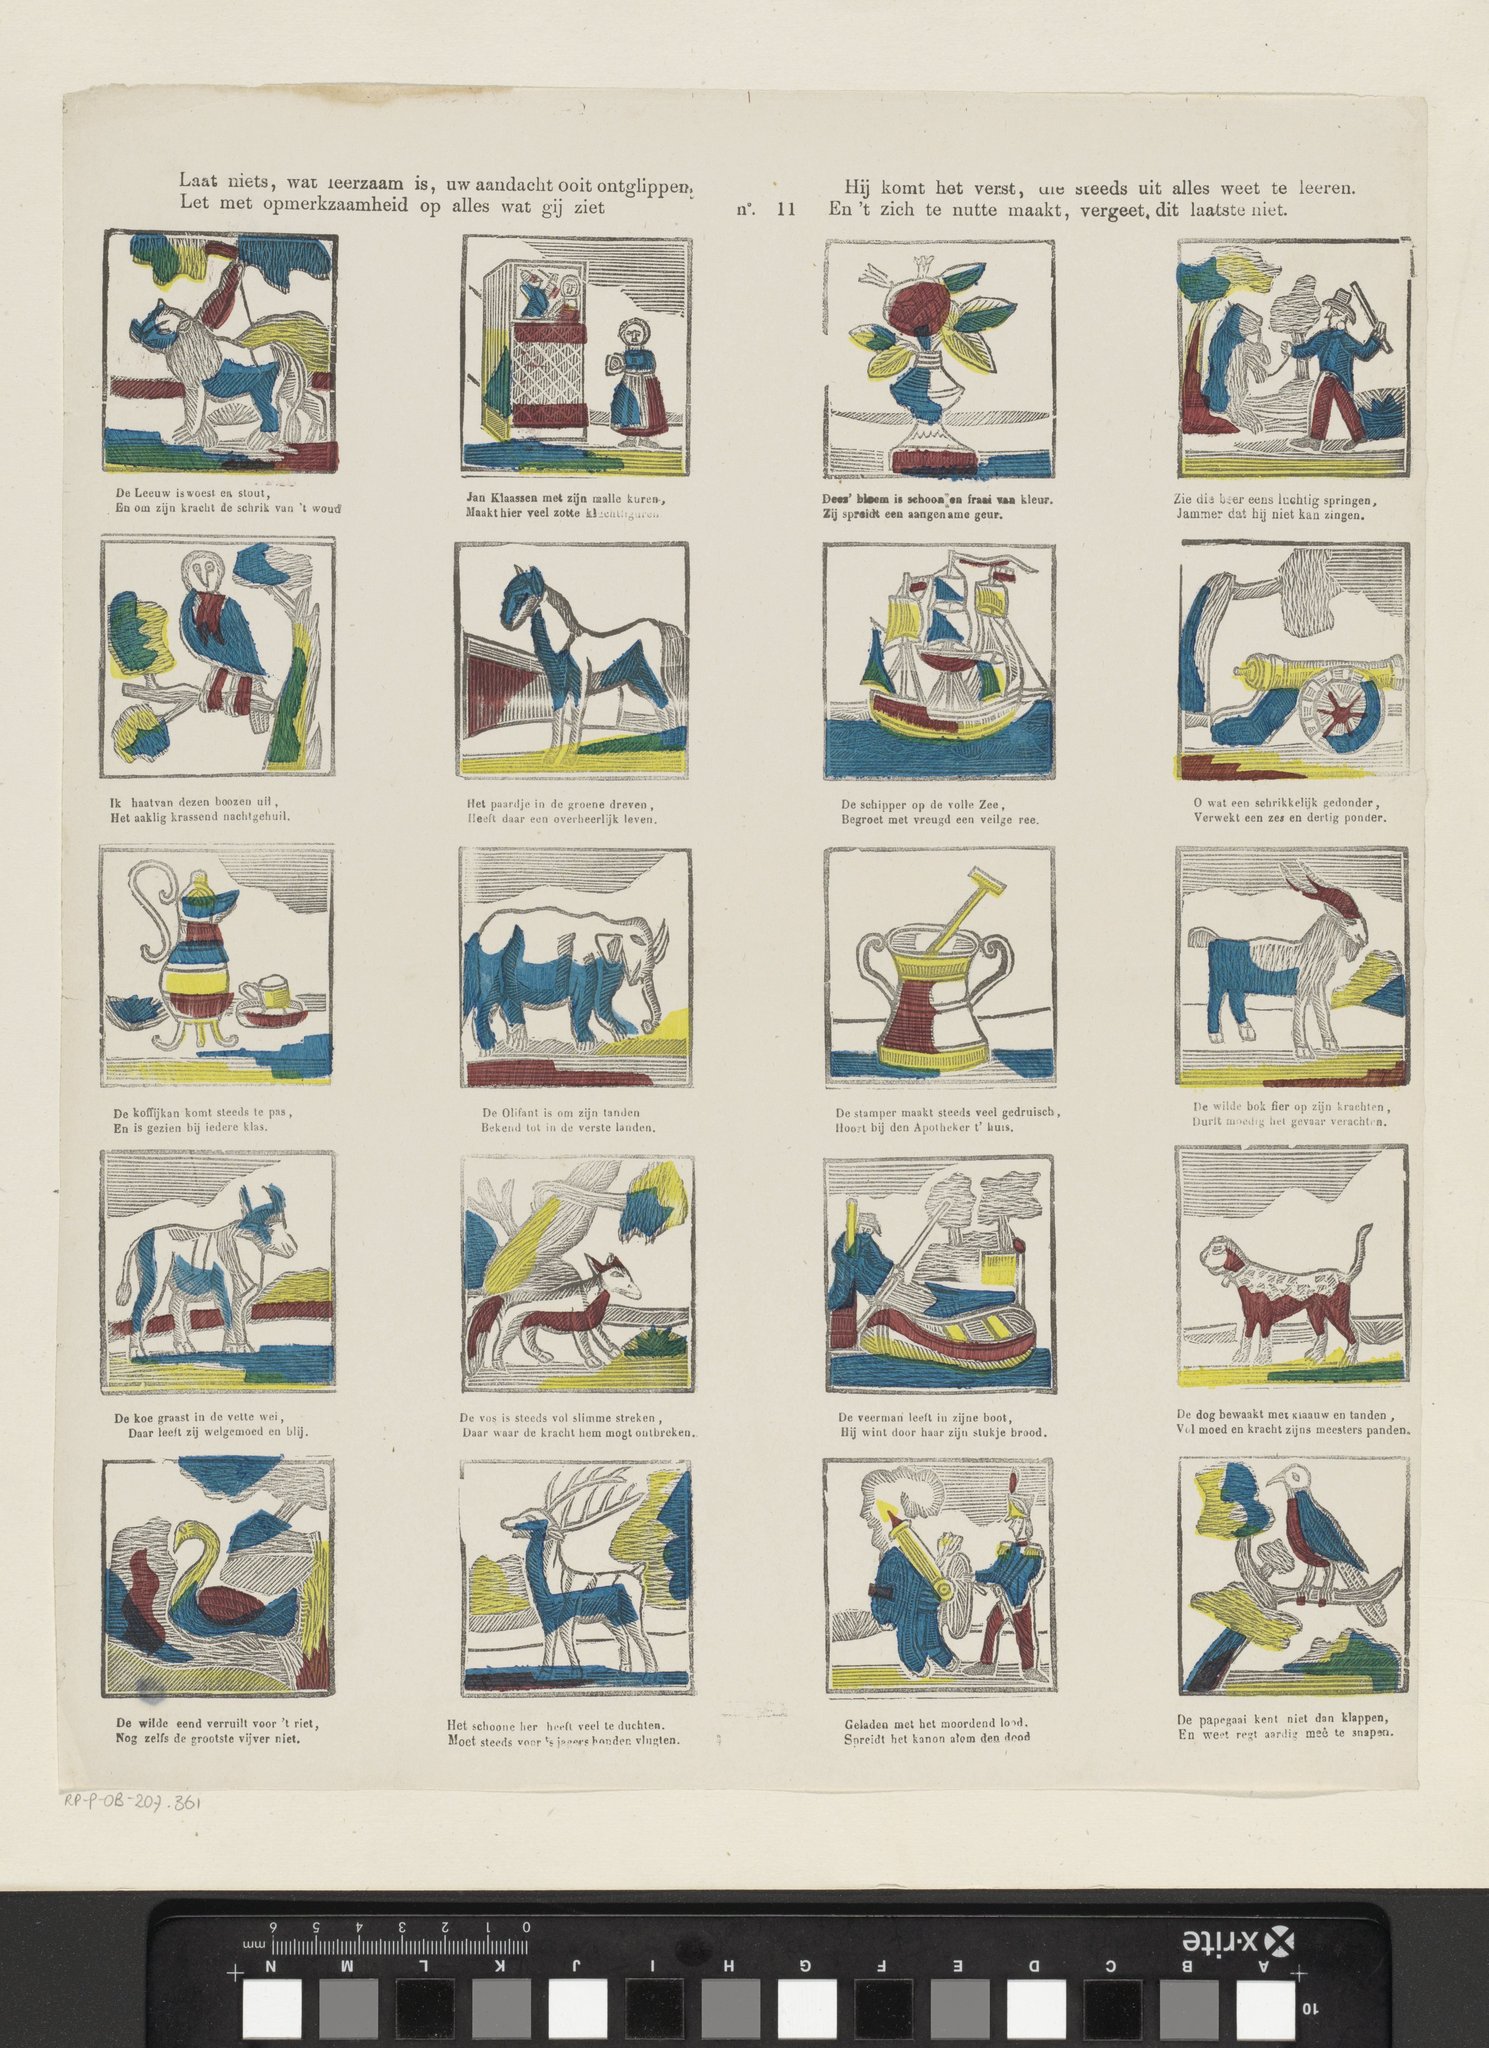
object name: popular print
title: Laat niets, wat leerzaam is, uw aandacht ooit ontglippen / Let met opmerkzaamheid op alles wat gij ziet / Hij komt het verst, die steeds uit alles weet te leeren. / En 't zich te nutte maakt, vergeet, dit laatste niet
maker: Anonymous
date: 1848-1881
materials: paper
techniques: colour, letterpress printing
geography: netherlands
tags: animals, firearms: cannon (+ handling of weapons), ships (in general)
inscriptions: collector's mark: Lugt 2760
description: Blad met 20 voorstellingen van voorwerpen, dieren en figuren. Onder elke voorstelling een tweeregelig vers. Genummerd midden boven: no. 11.